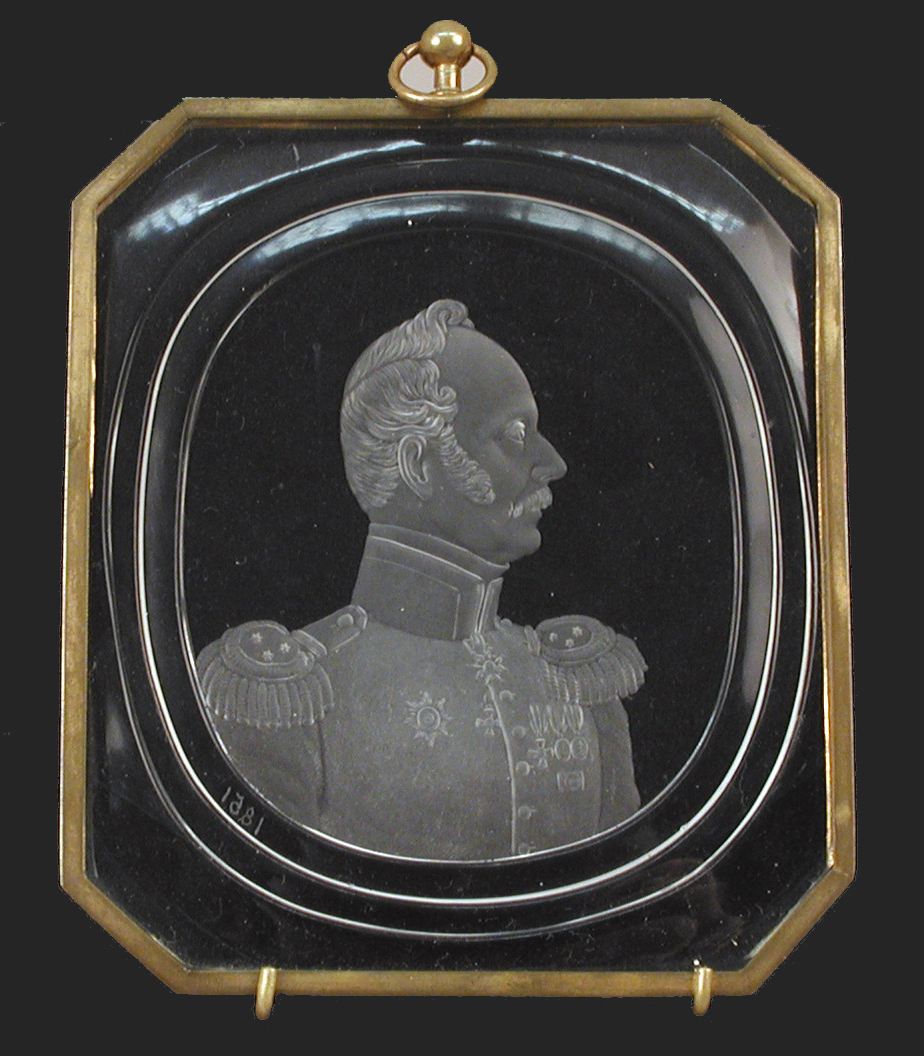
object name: medallion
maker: dominik bimann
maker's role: engraver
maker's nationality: bohemian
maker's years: 1800-1857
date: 1851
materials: glass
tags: men,profiles